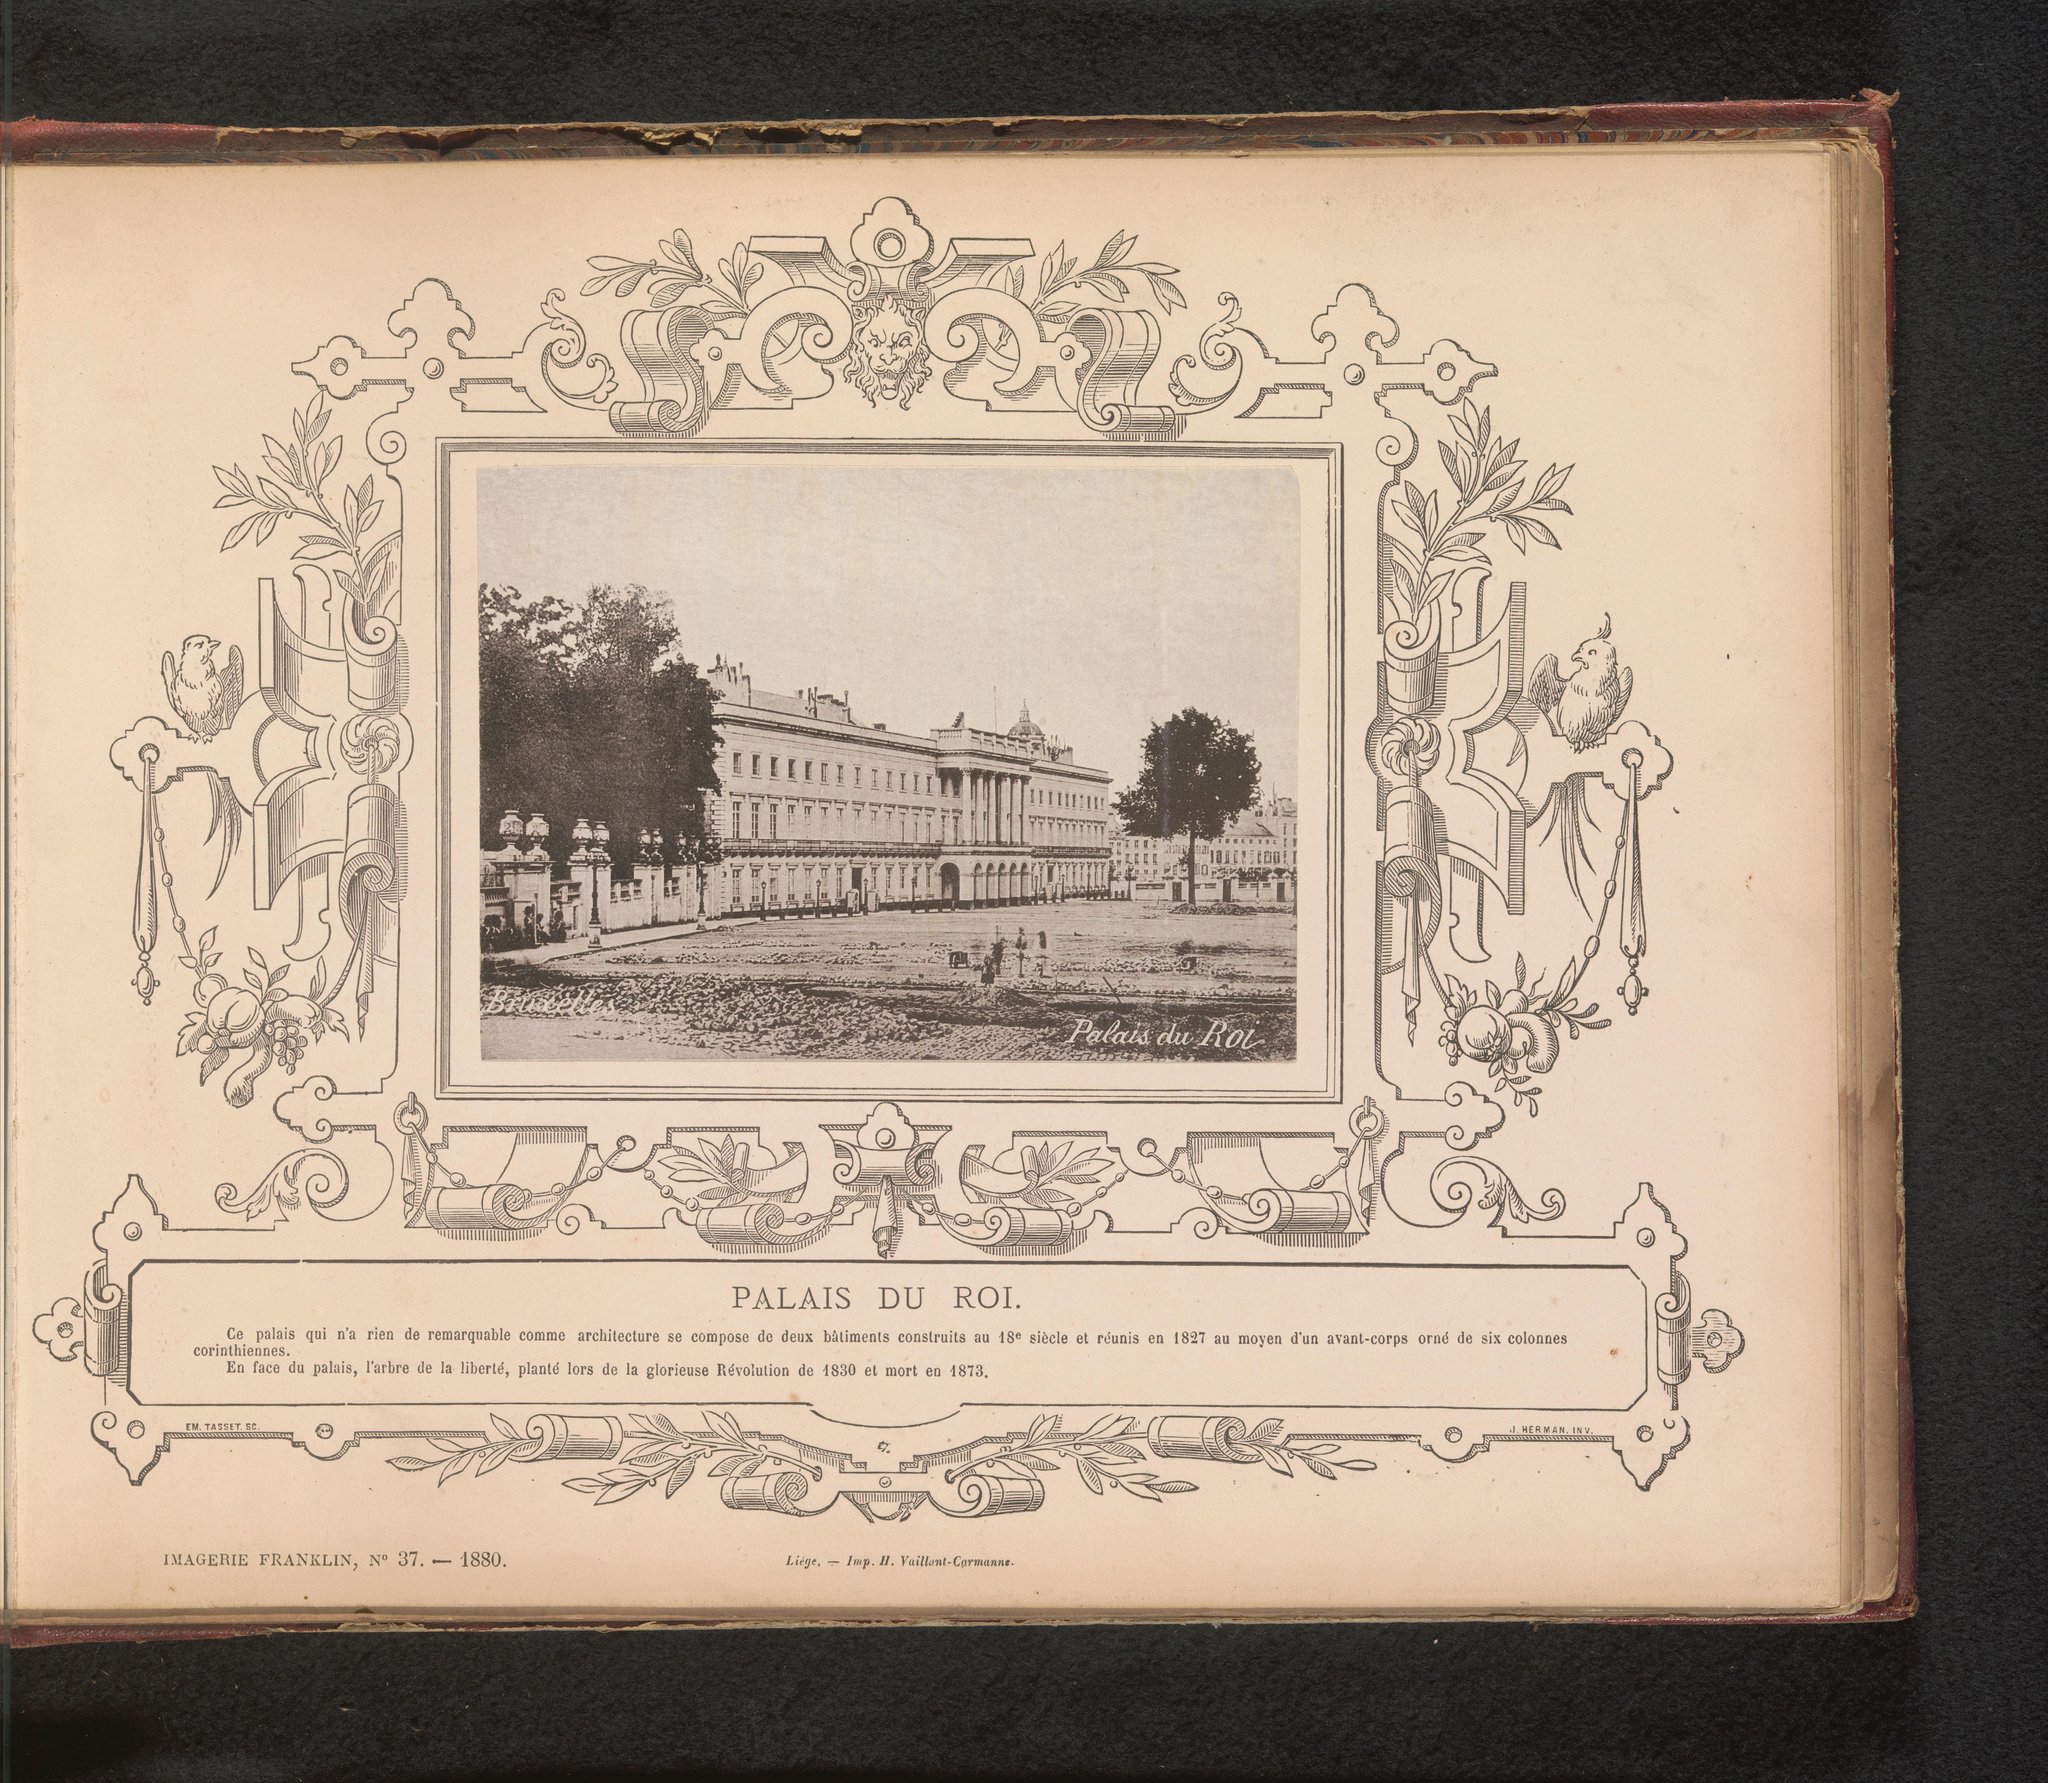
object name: page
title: Bruxelles Palais du Roi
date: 1875-1880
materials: paper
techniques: photograph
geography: liège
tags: palace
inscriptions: name: ‘J. HERMAN, INV.’, inscription: ‘IMAGERIE FRANKLIN, No 37. -1880.’, inscription: ‘Ce palais qui n'a rien de remarquable comme architecture se compose de deux bâtiments construits au 18e siècle et réunis en 1827 au moyen d'un avant-corps orné de six colonnes/ corinthiennes./ En face du palais, l'arbre de la liberté, planté lors de la glorieuse Révolution de 1830 et mort en 1873.’, name: ‘EM. TASSET, SC.’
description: Deze prent maakt deel uit van een album.